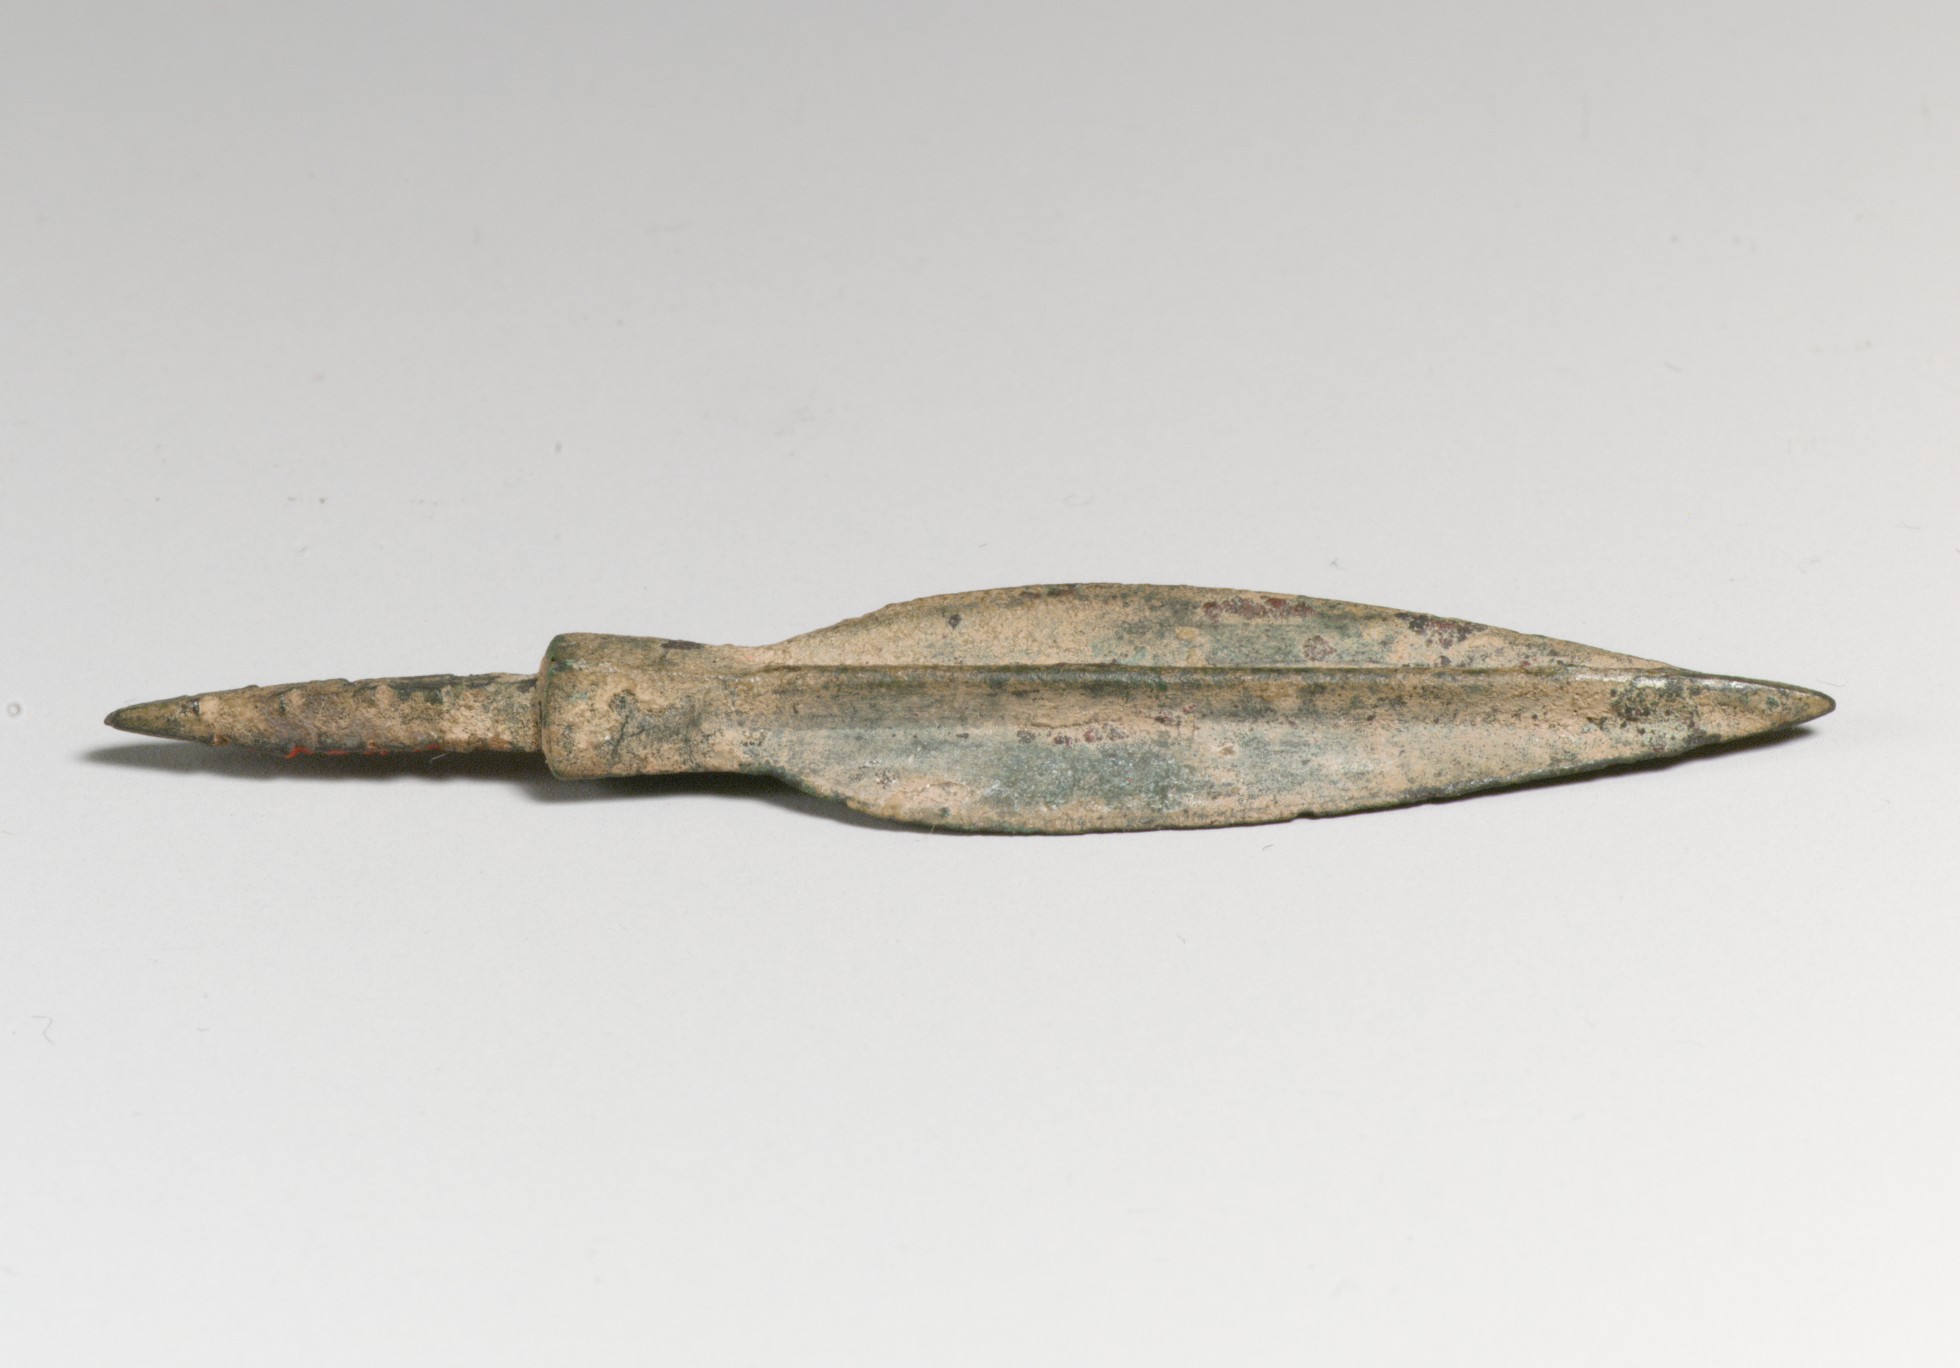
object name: arrowhead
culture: cypriot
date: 3900 BCE-100 CE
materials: bronze